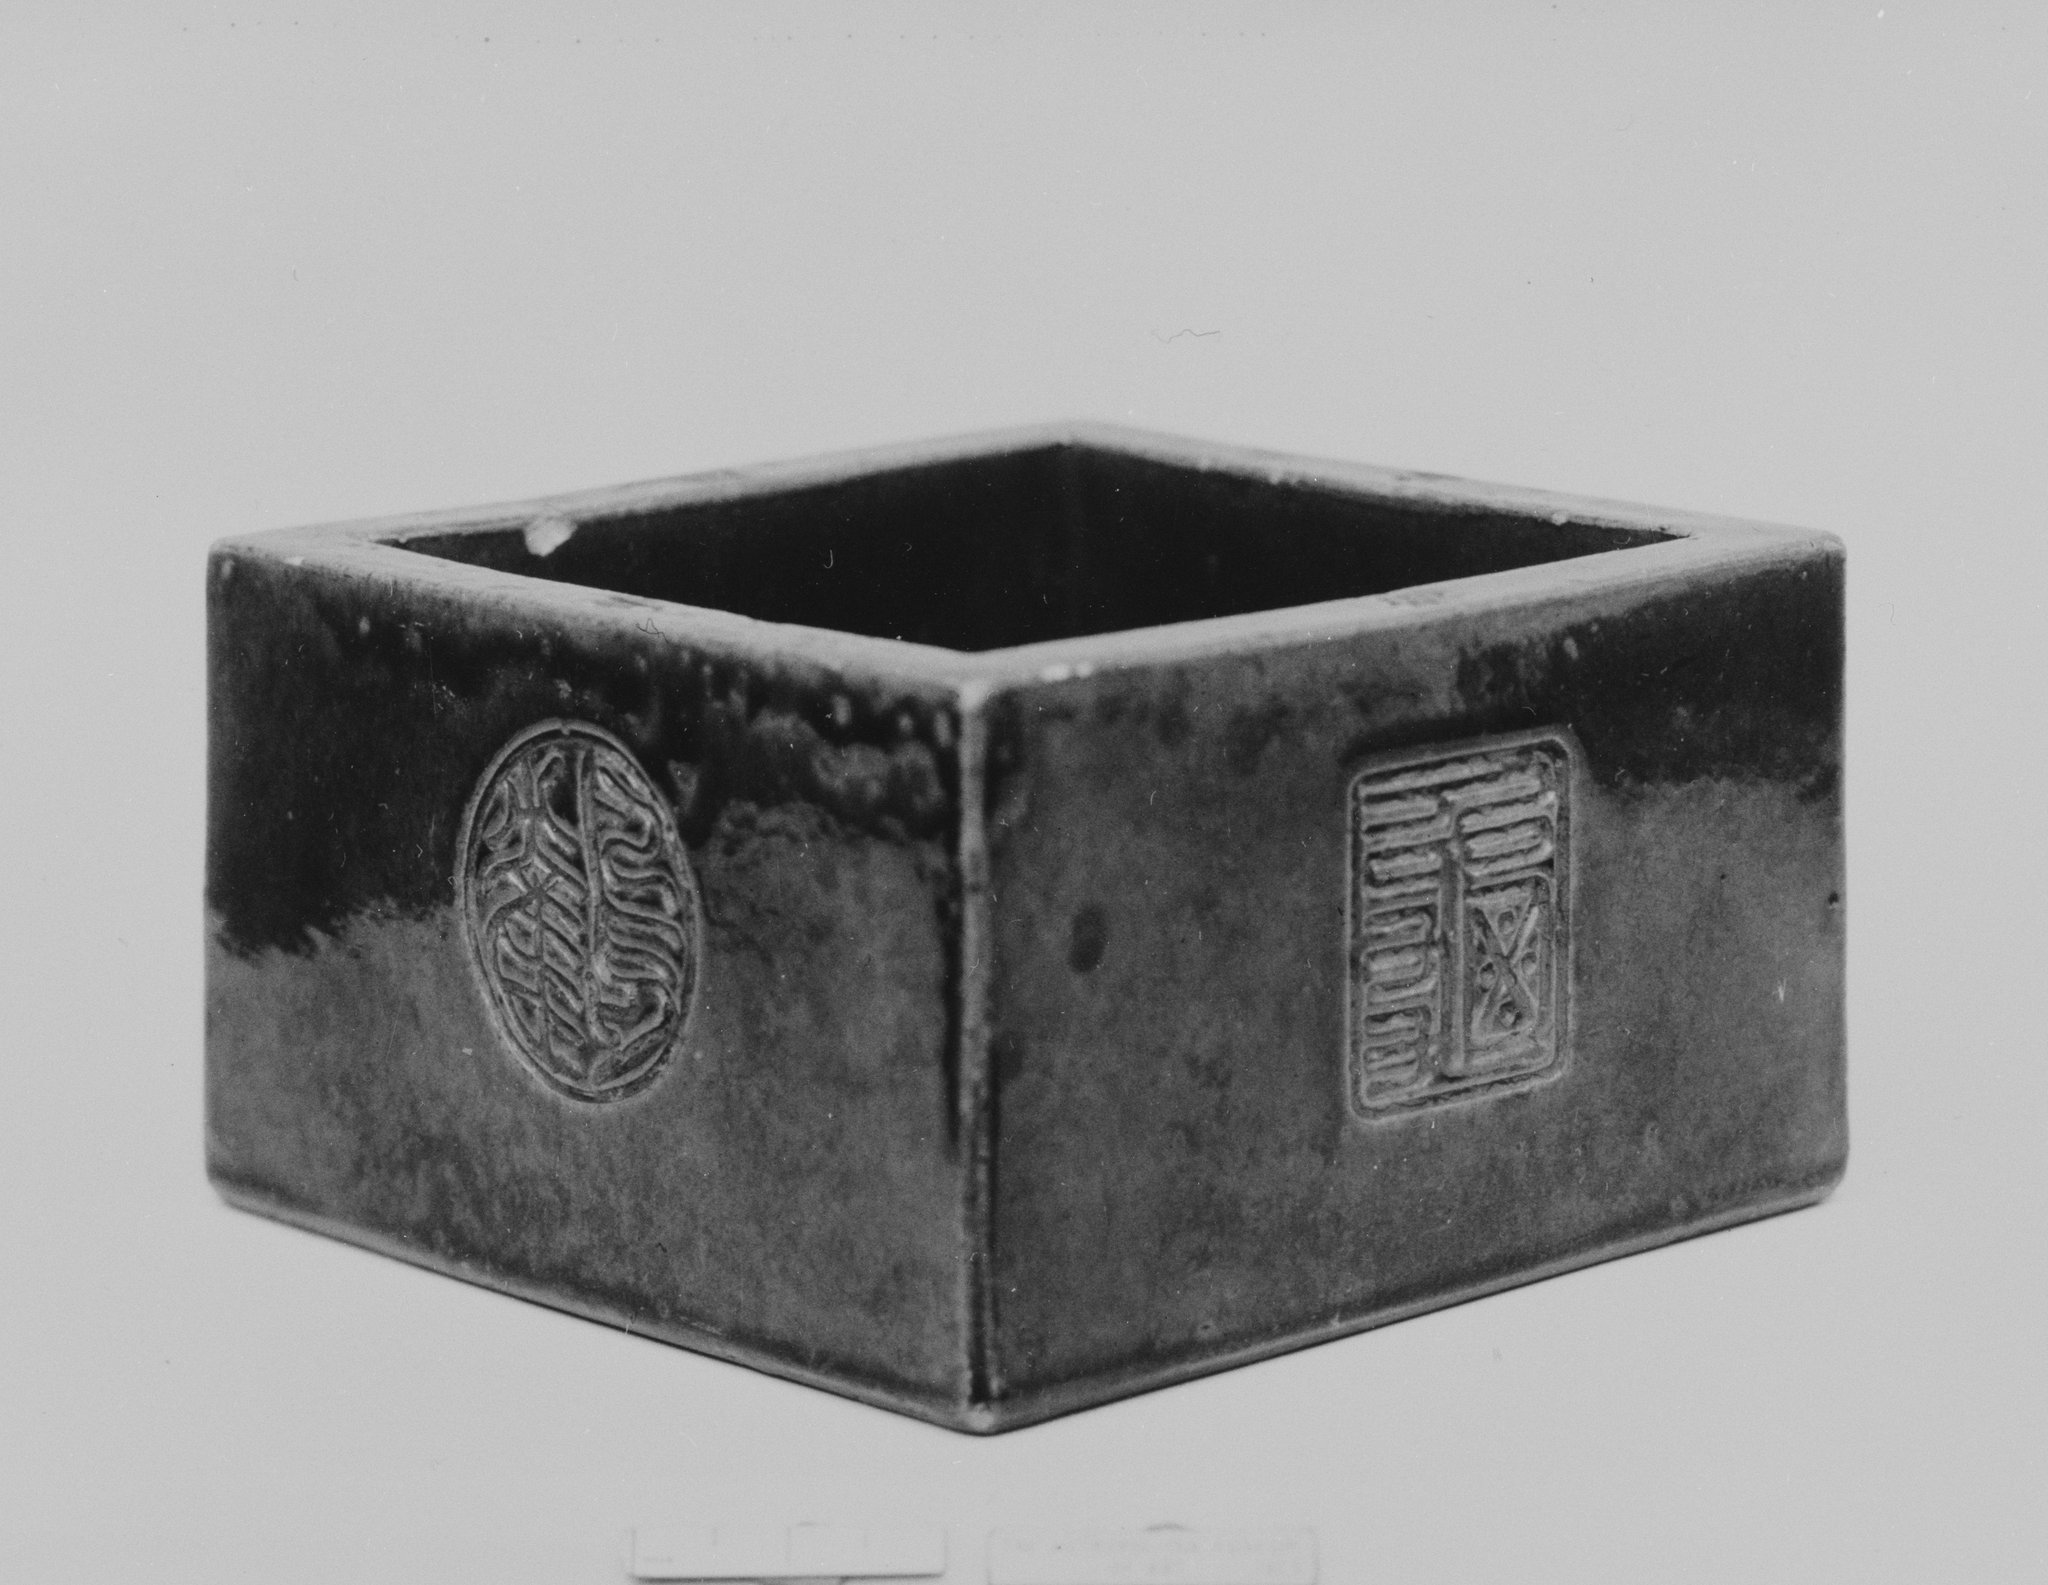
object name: dish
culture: japanese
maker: kikko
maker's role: artist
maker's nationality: japanese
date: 1850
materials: faience, glaze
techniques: incising